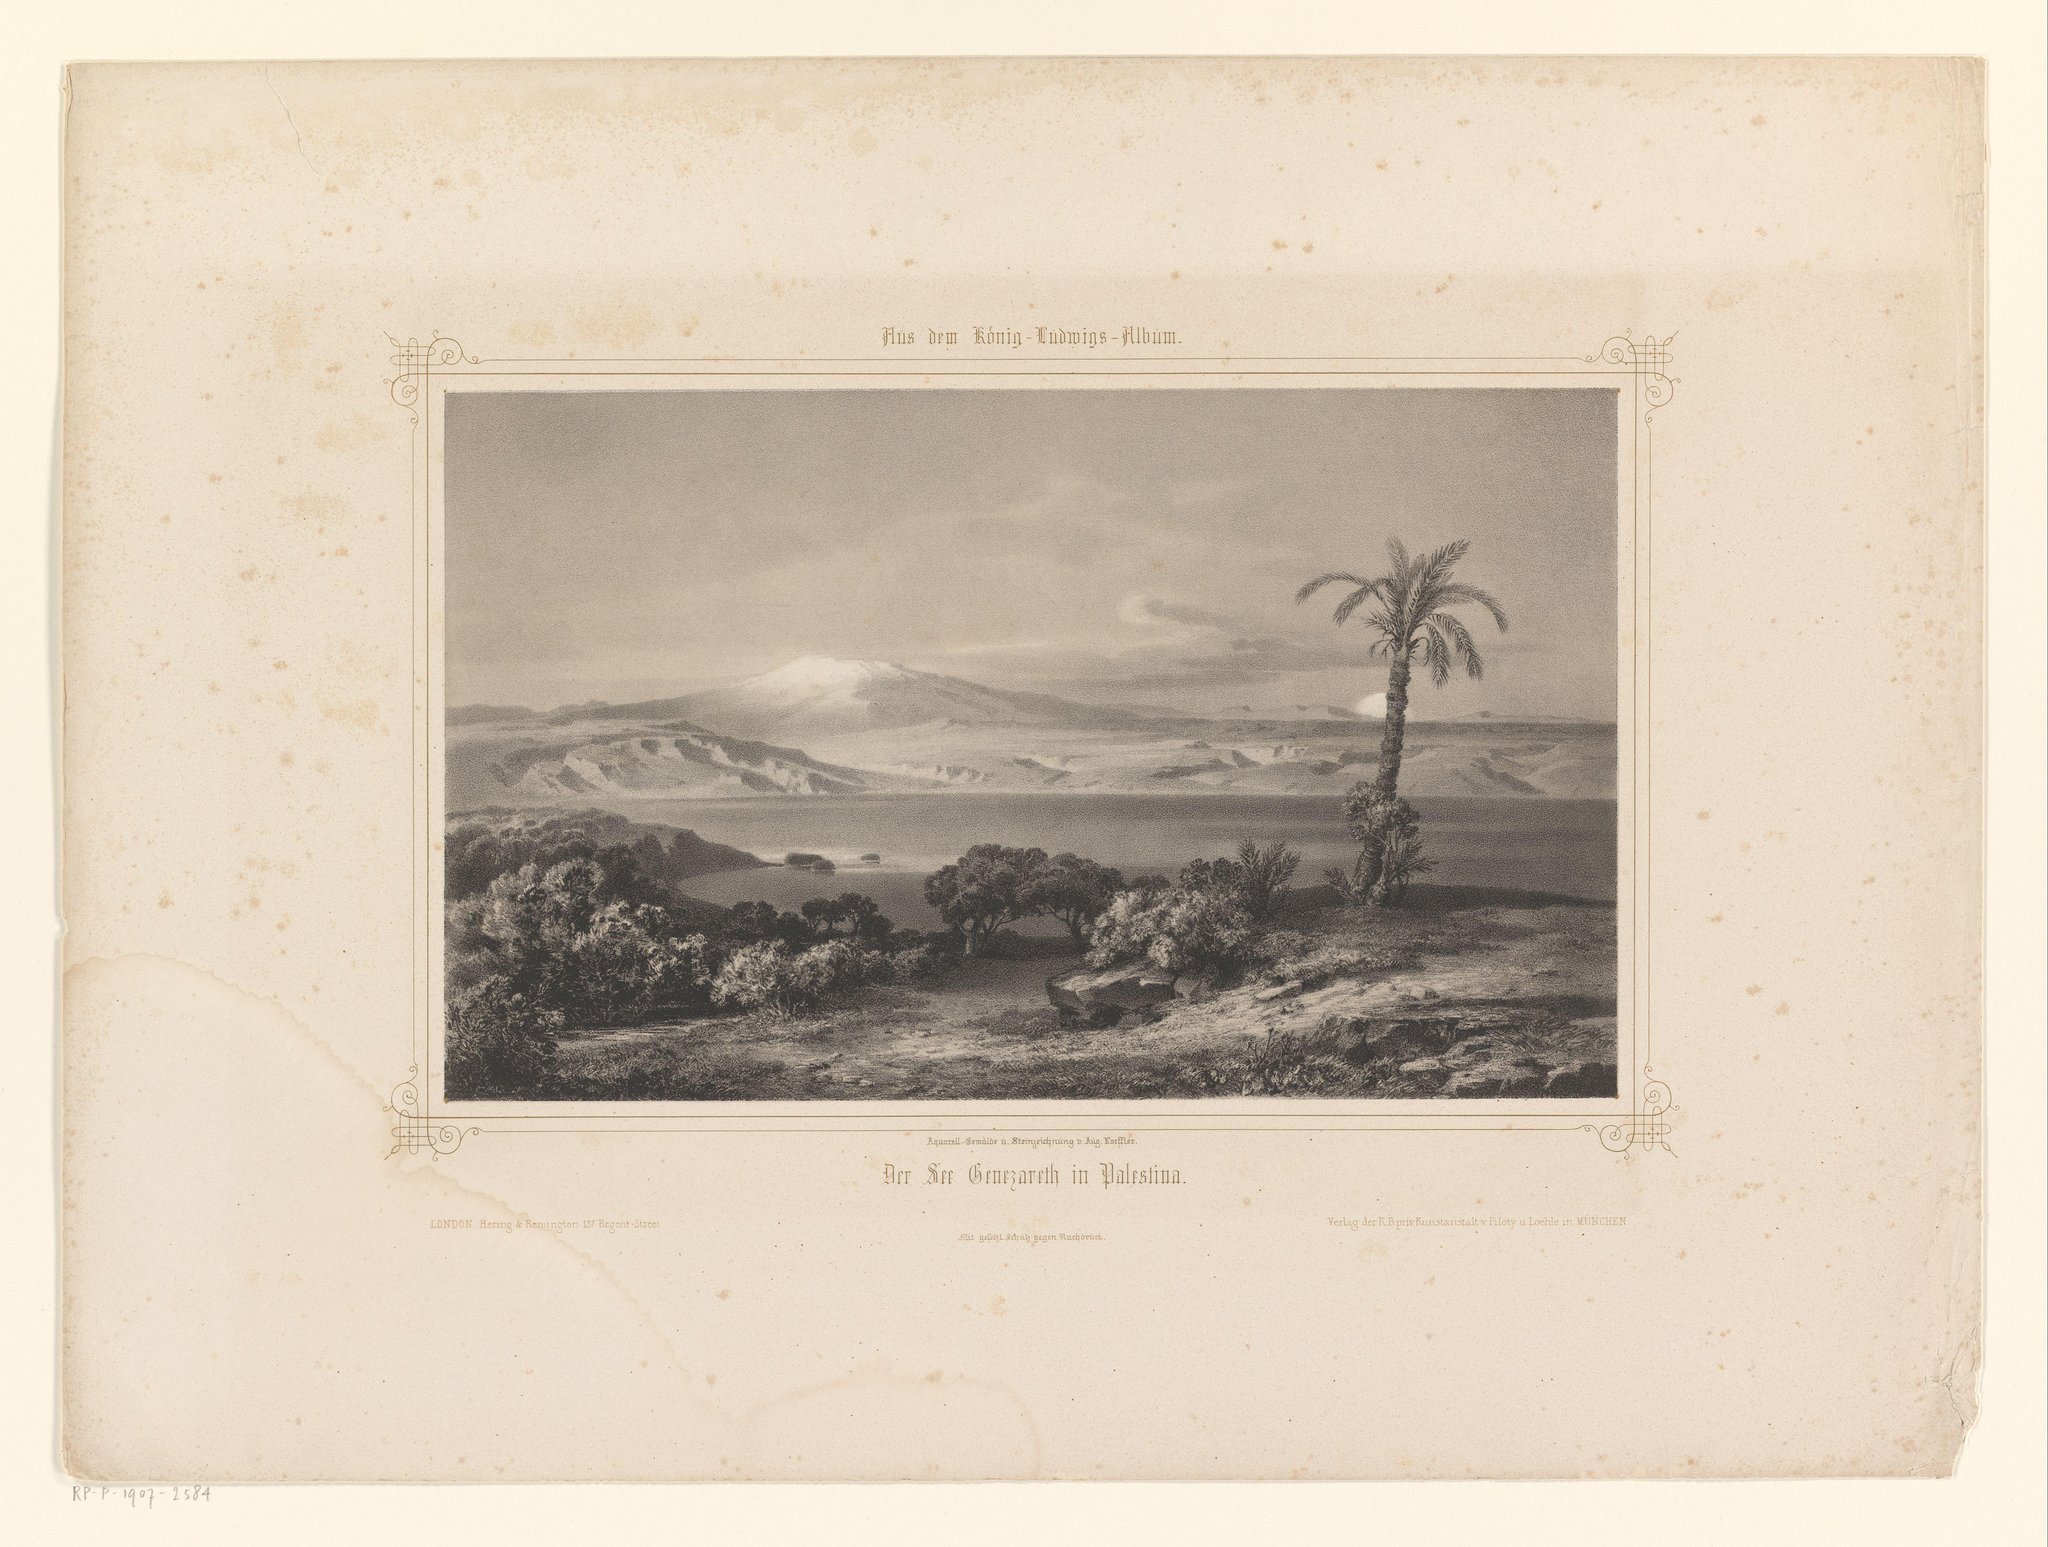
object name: print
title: Meer van Tiberias te Palestina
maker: august löffler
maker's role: print maker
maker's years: 1822-1866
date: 1850-1859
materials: paper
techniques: tone lithography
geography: munich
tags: lake, trees: palm-tree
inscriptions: collector's mark: Lugt 2228, check stamp: ‘Piloty&Loehle, München’, : ‘Mit gesetzl Schutze gegen Nachbildung’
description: Prent afkomstig uit de serie 'Album Seiner Majestät des Königs Ludwig I. von Bayern', verschenen in verschillende afleveringen. De prenten gaan terug op het album dat Lodewijk I van Beieren op 9 oktober 1850 kreeg overhandigd van verschillende kunstenaars.